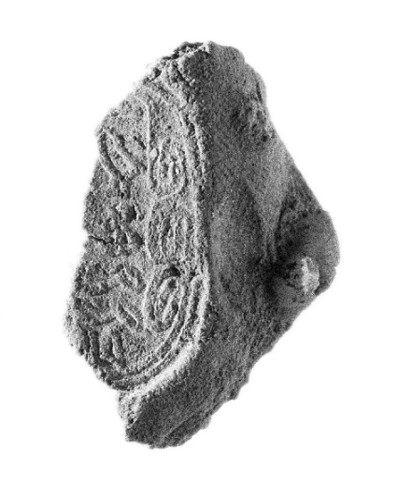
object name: sealing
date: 1981-1640 BCE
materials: mud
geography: egypt